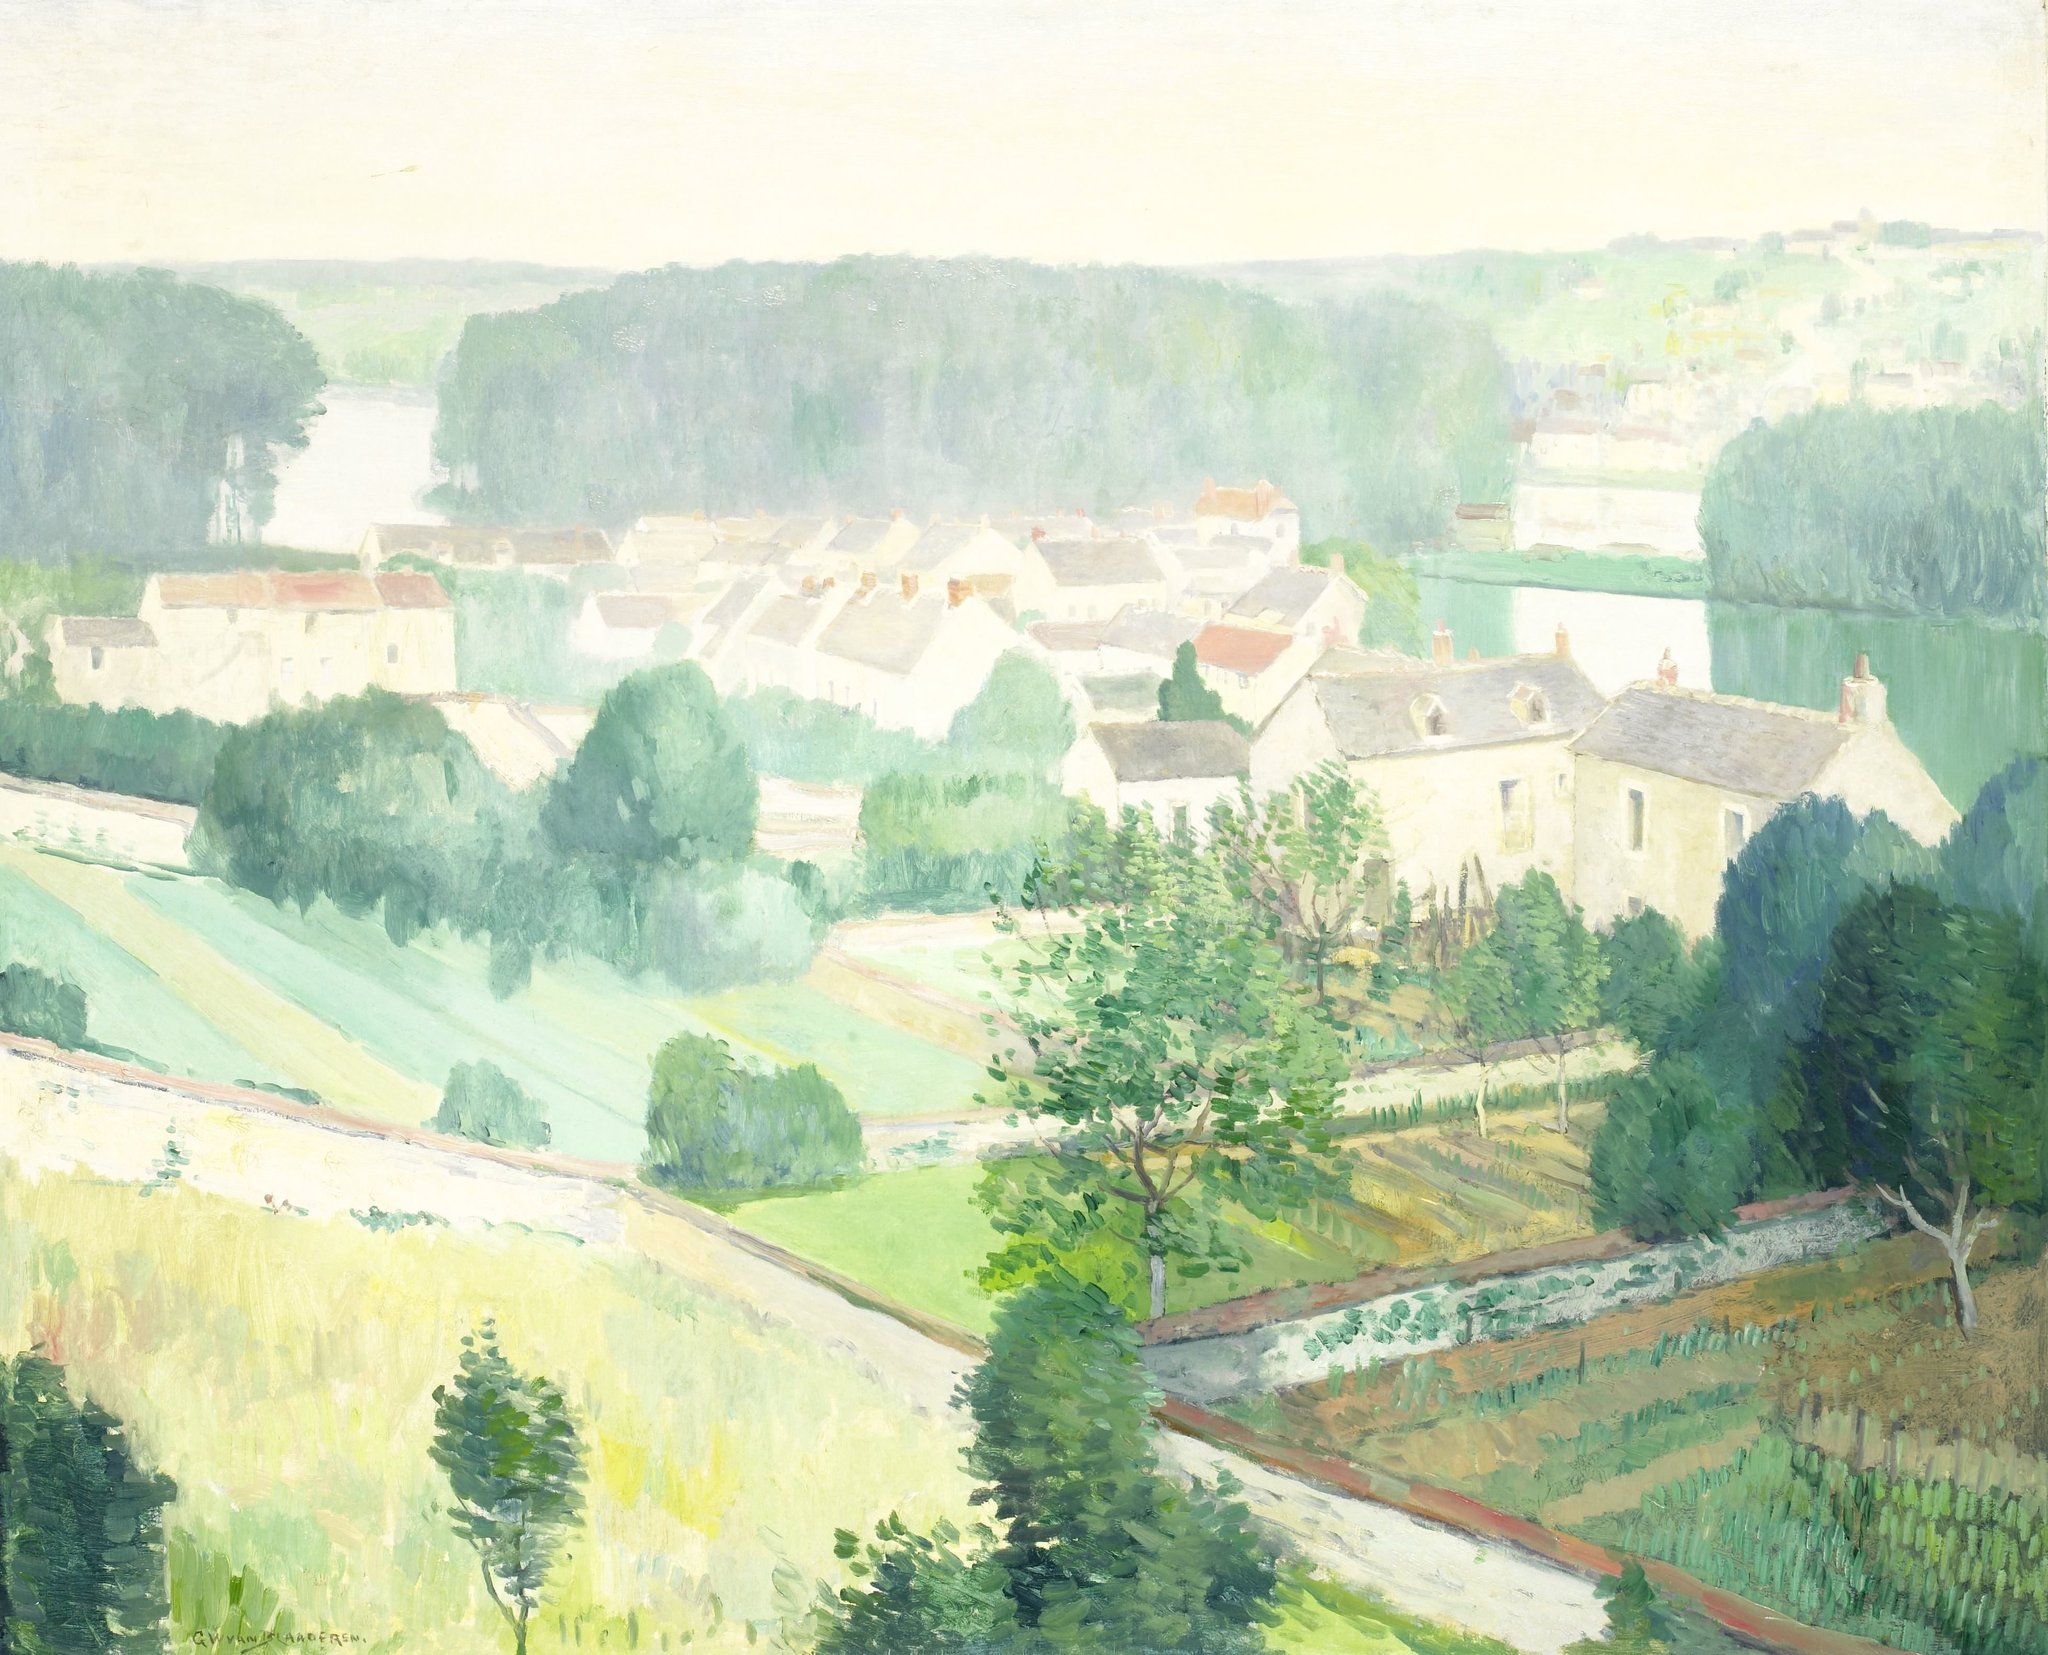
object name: painting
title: The Village of Sannois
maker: gerrit van blaaderen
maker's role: draughtsman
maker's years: 1873-1935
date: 1910-1914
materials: canvas, oil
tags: prospect of village, silhouette of village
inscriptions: signature: ‘G.W. van Blaaderen’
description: Landschap met gezicht vanaf een heuvel op het dorp Sannois in Frankrijk.